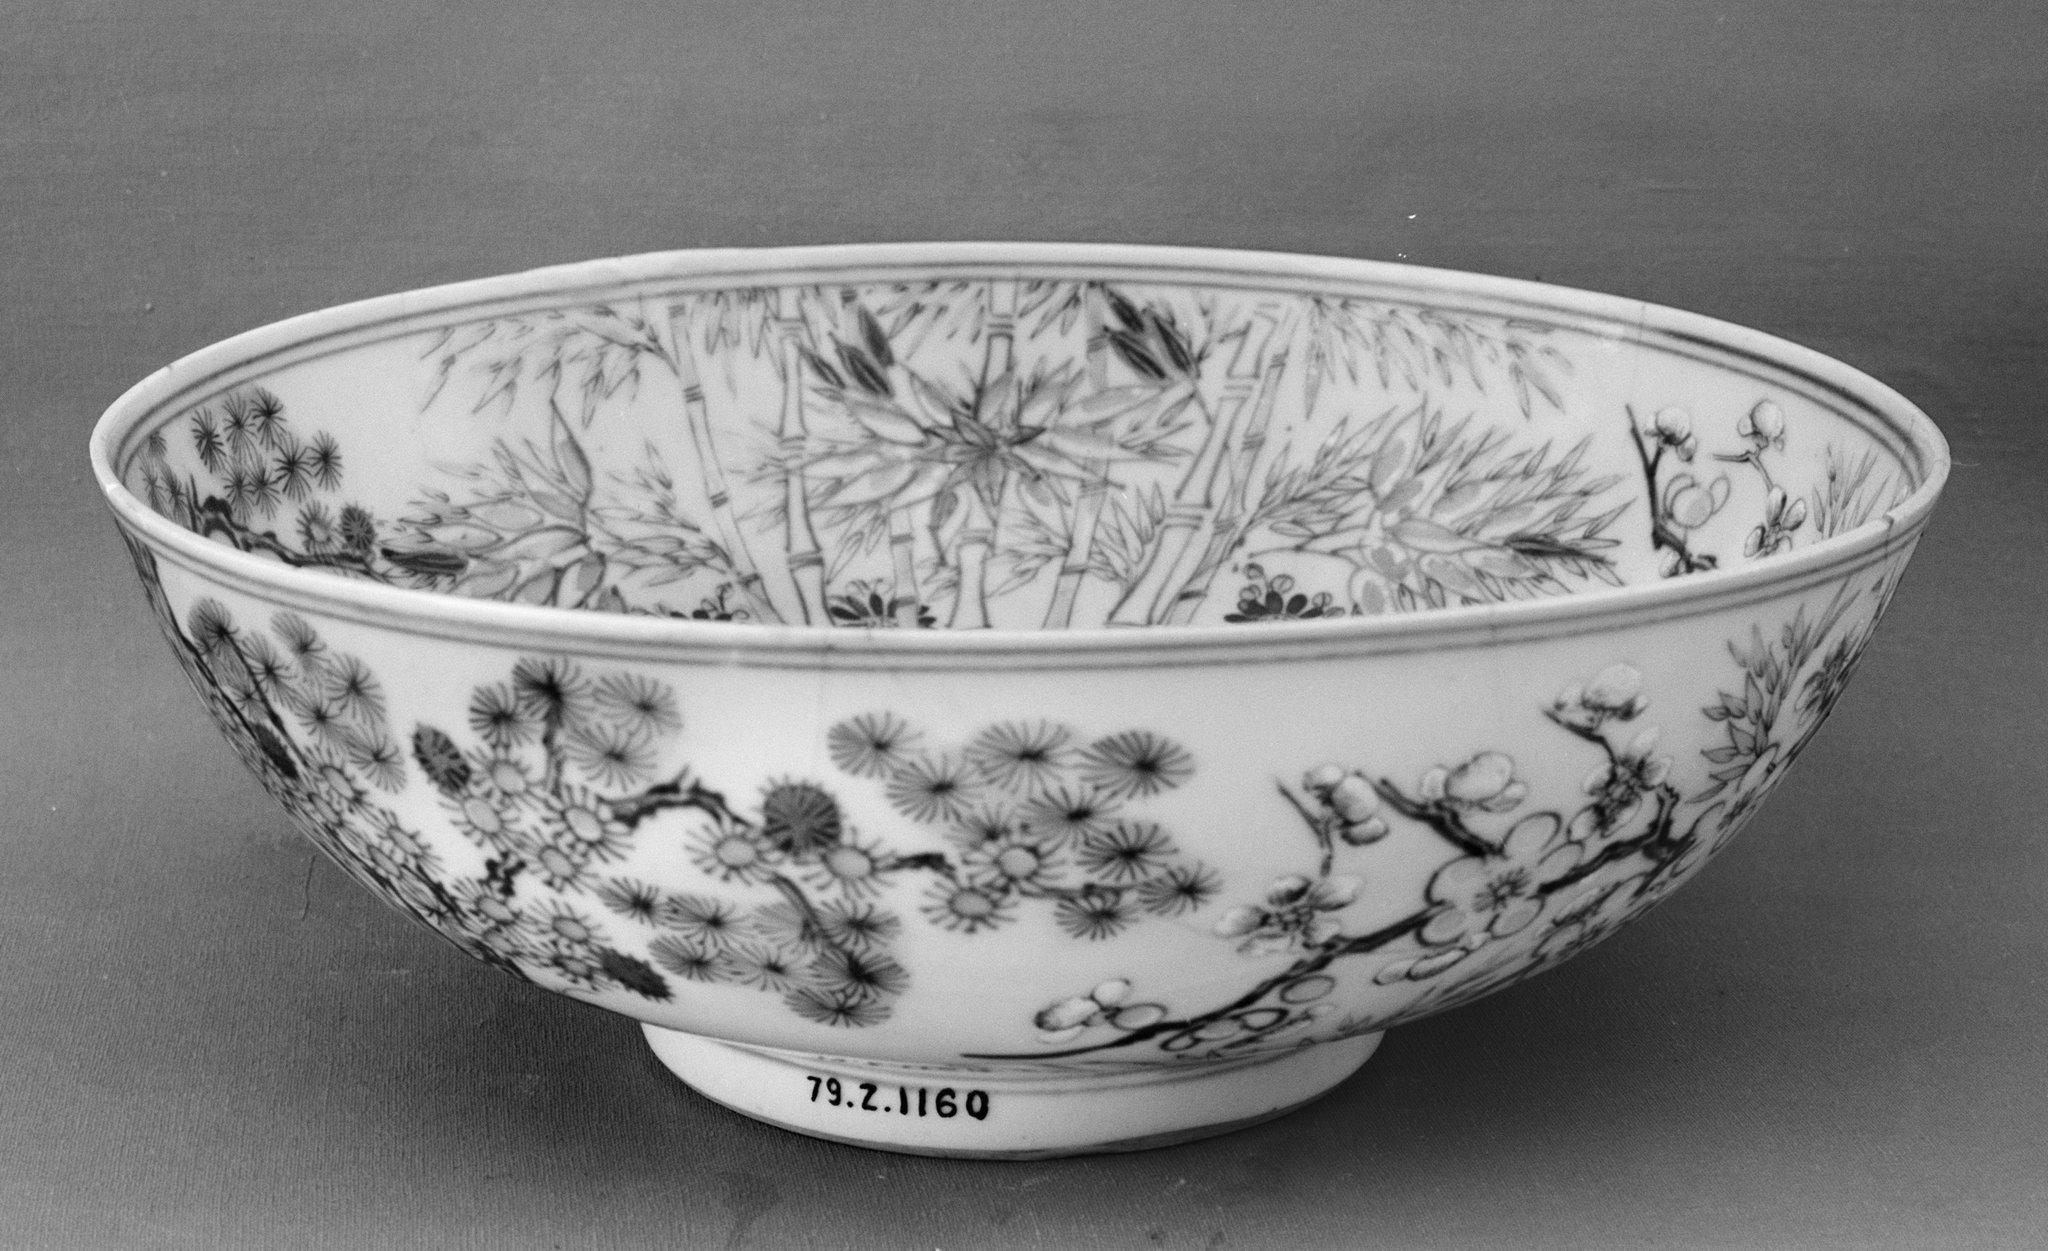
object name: bowl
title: Bowl with bamboo, pine tree, and blossoming plums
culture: chinese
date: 1767-1800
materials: cobalt, enamel, porcelain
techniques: painting, polychrome, underglaze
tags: flowers,bamboo